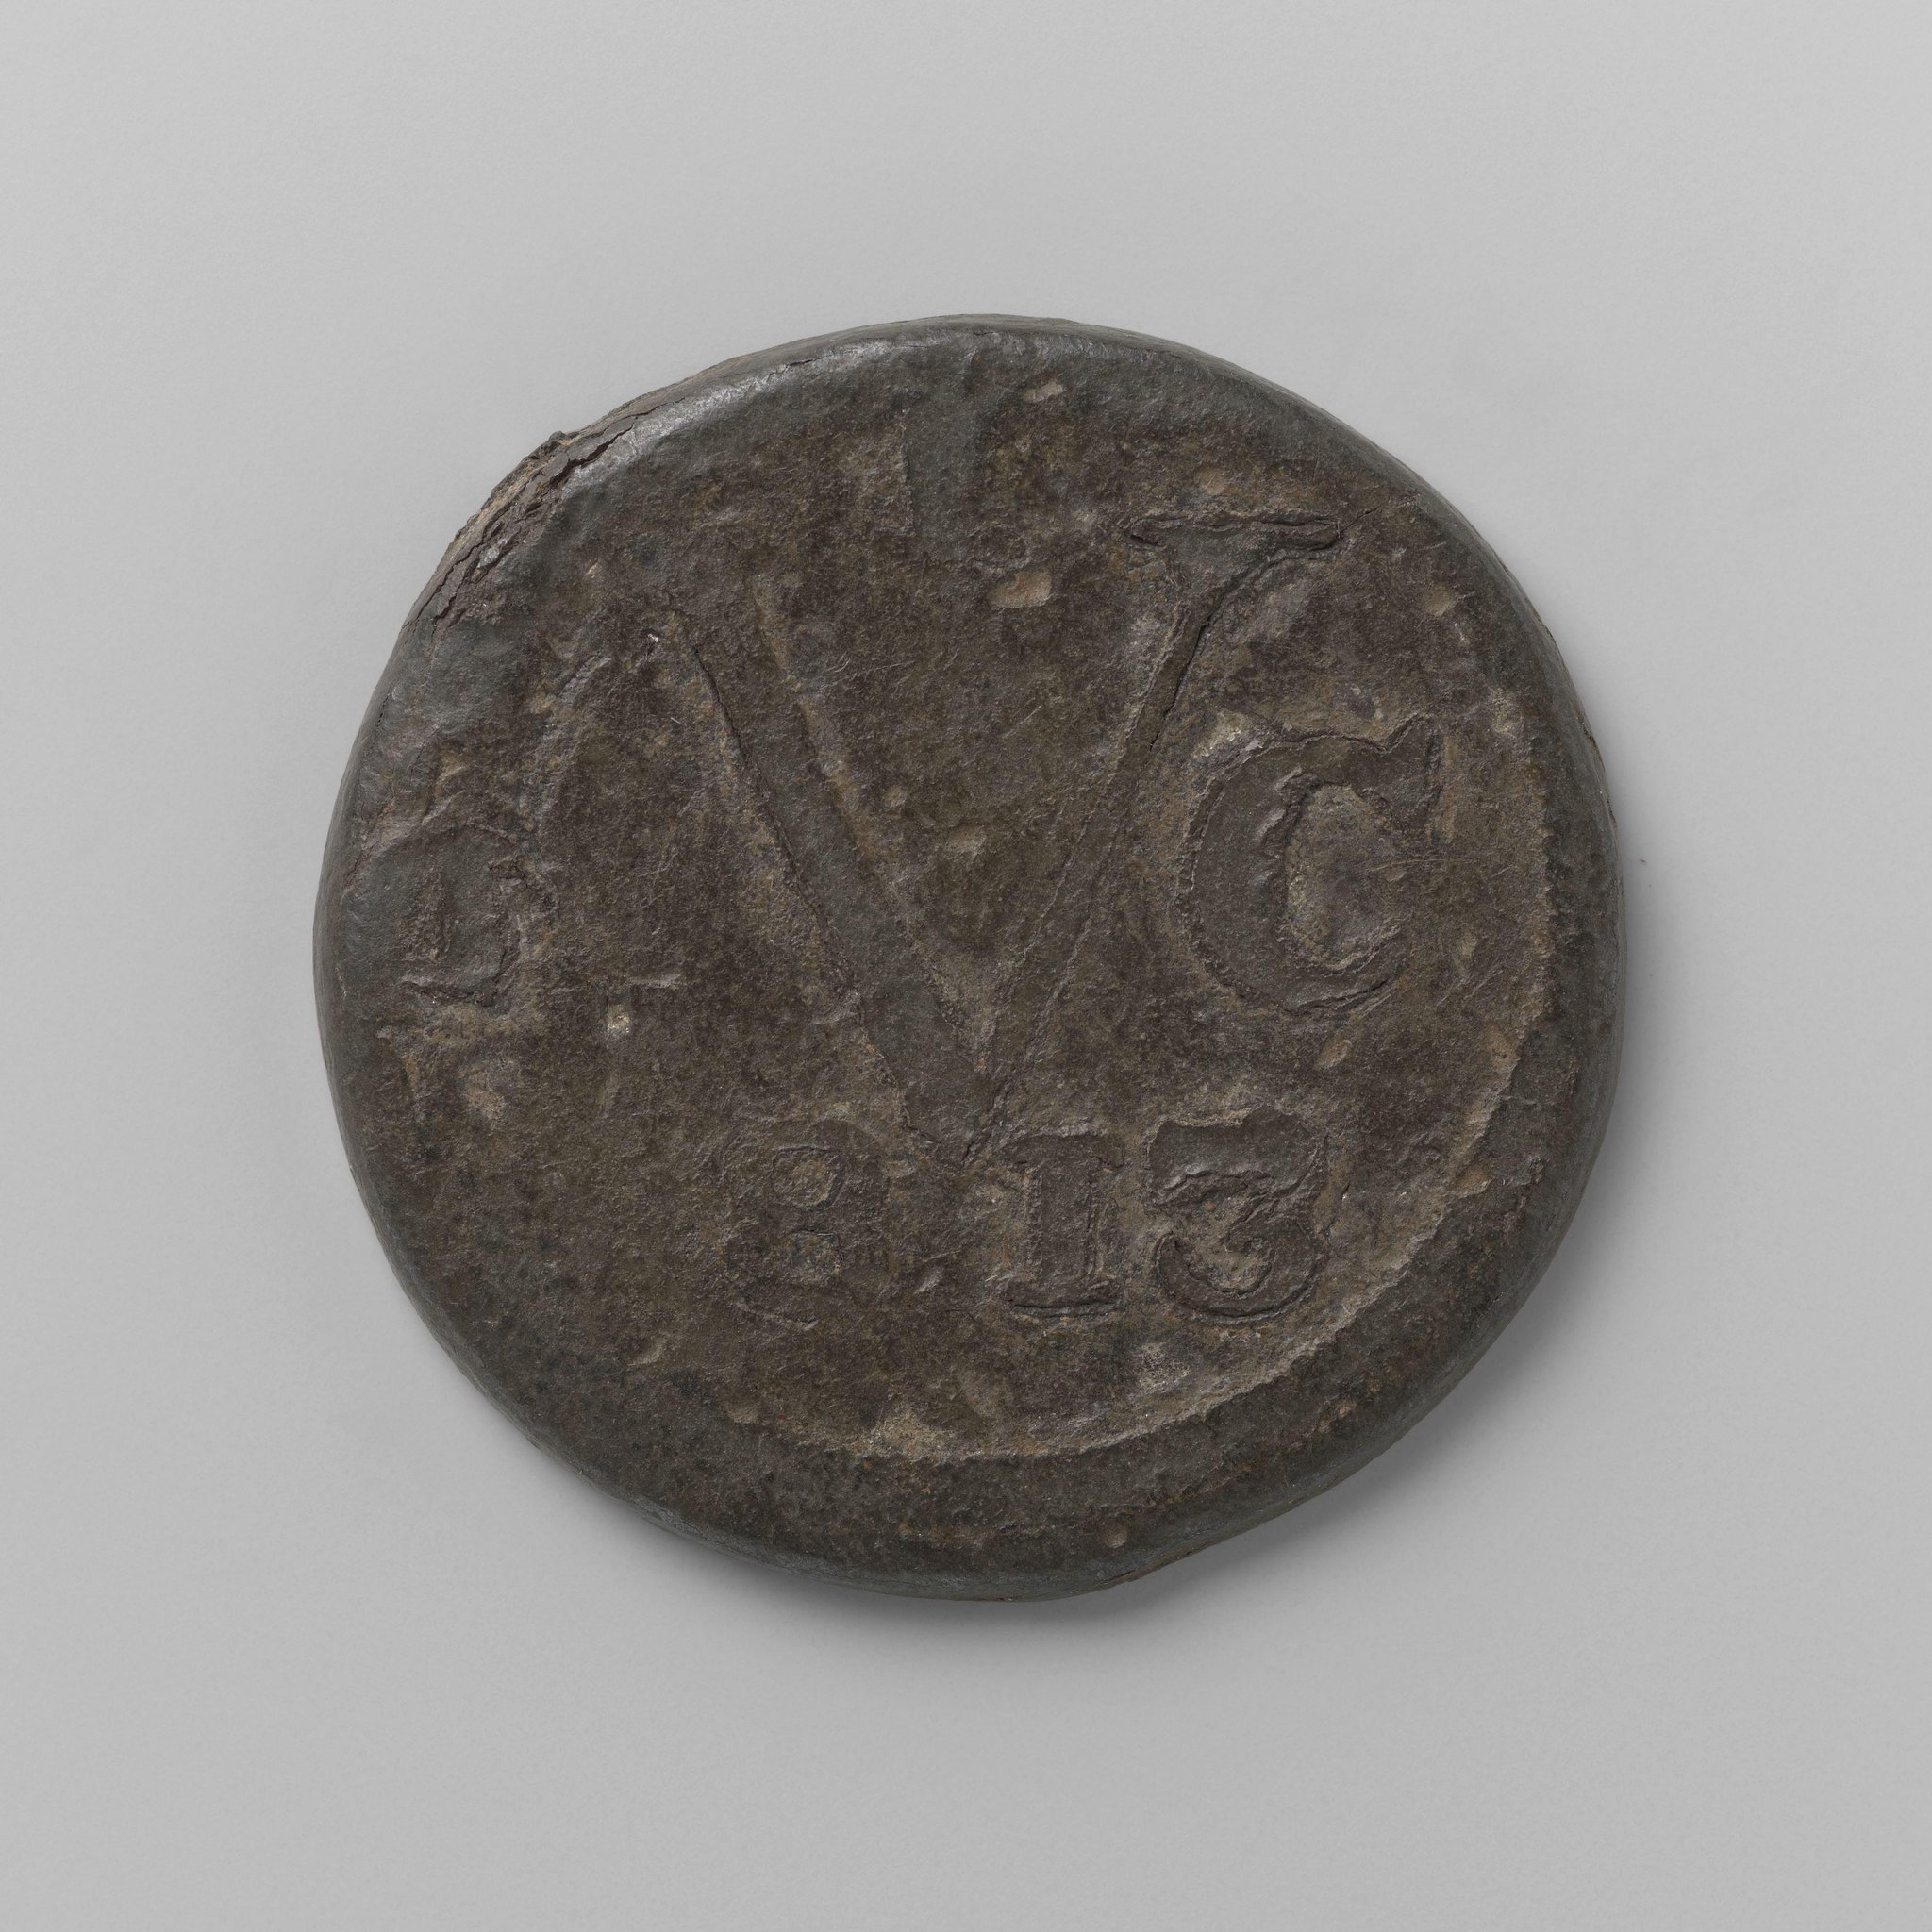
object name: coin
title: Duit voor Nederlands Indië tijdens Brits bestuur,1813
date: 1813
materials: tin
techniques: striking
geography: batavia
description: Tinnen munt. Voorzijde: Letter V tussen letters E en C. Boven deze letters letter I en onder deze letters jaartal. Keerzijde: op twee regels waarde-aanduiding: 1 doit. Daaronder opschrift: Java, waaronder jaartal.